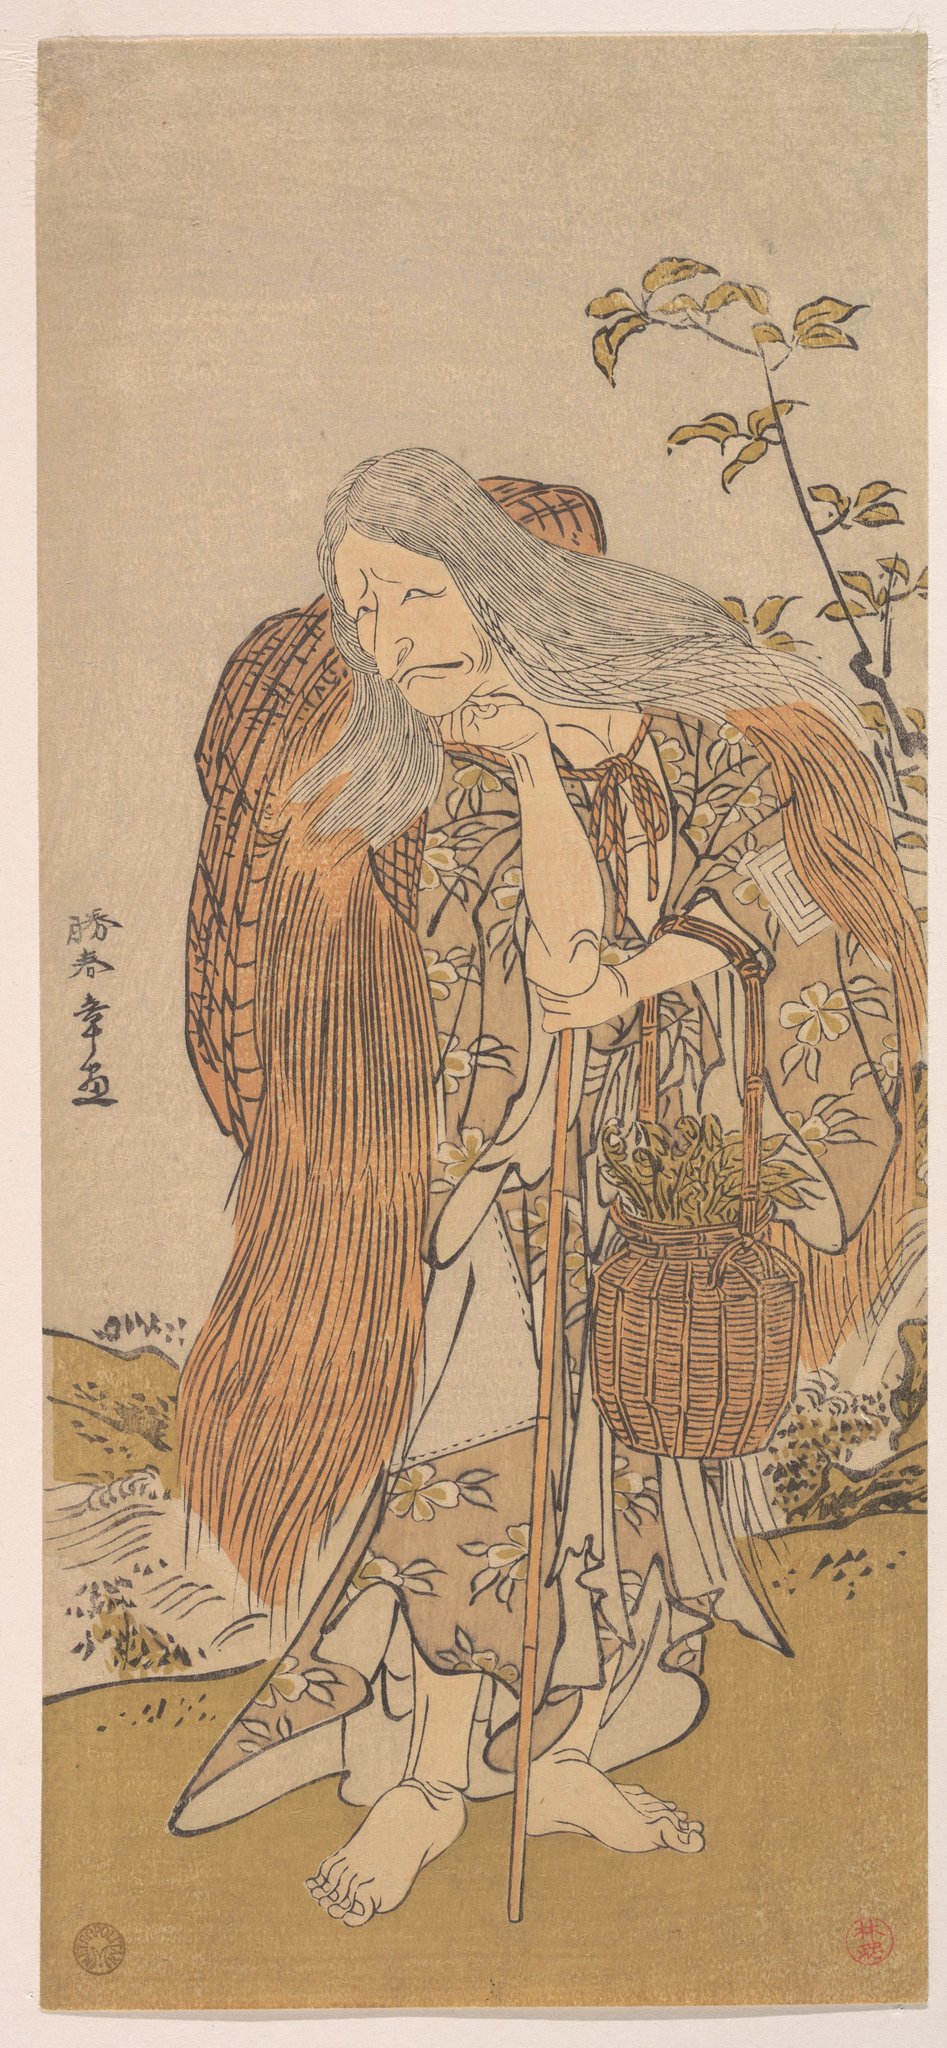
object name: woodblock print nishiki e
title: Ichikawa Danjūrō V in the Role of Shiromasu-baba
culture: japanese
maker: katsukawa shunshō 勝川春章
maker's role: artist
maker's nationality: japanese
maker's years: 1726-1792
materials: ink, paper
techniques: nishiki e, woodblock print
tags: men,actors